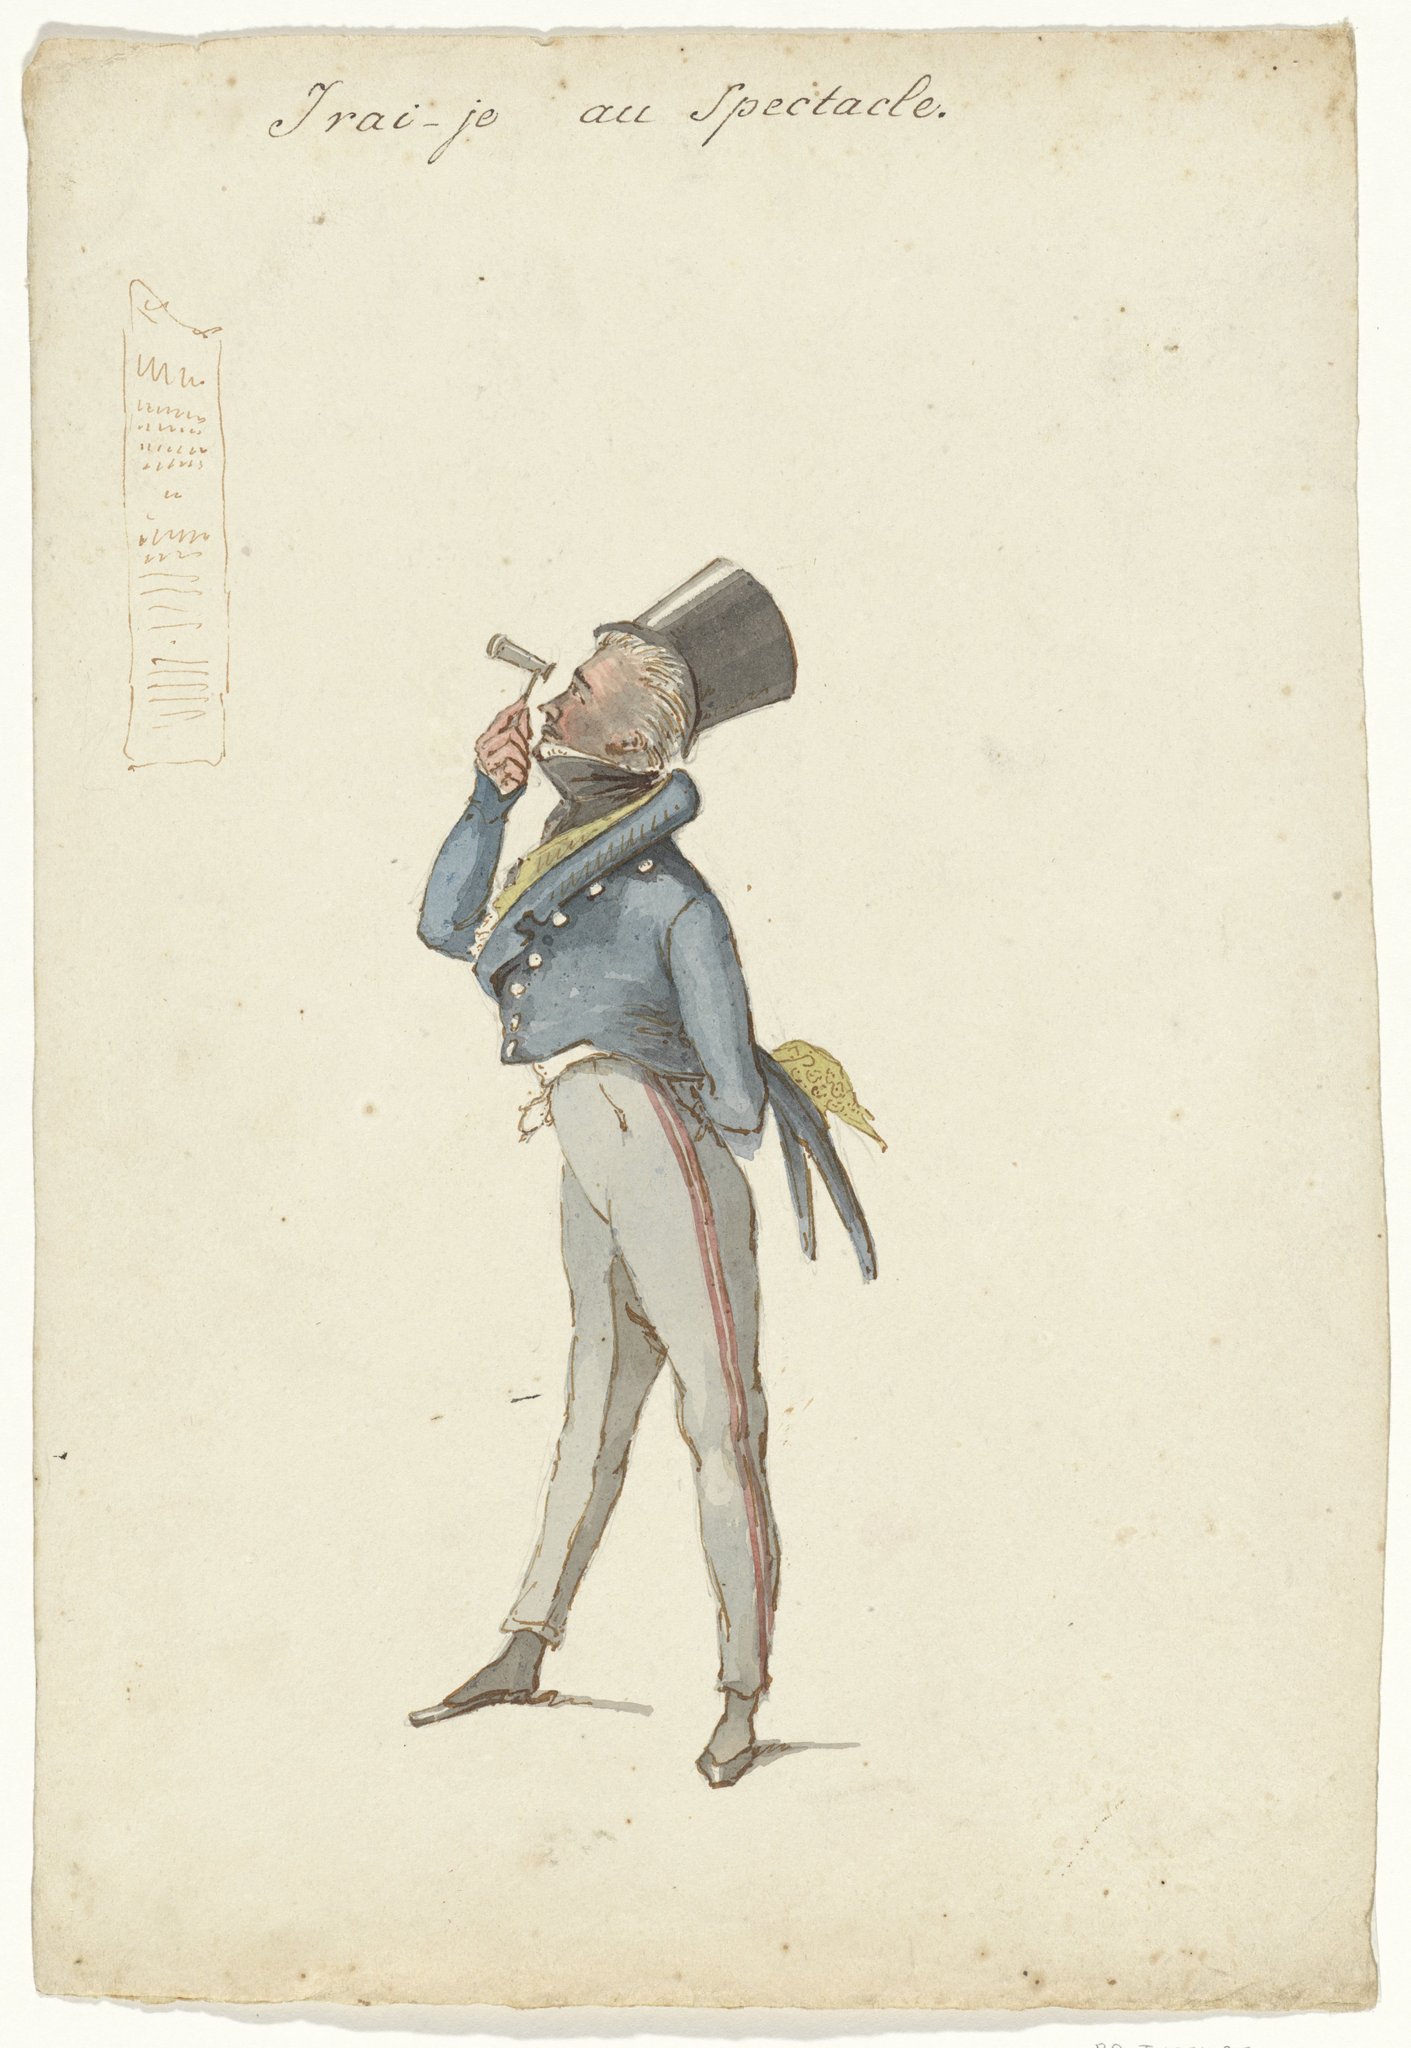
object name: drawing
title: Staande man met verrekijkertje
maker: pieter van loon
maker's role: draughtsman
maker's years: 1801-1873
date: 1811-1873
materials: ink, paper, pencil, watercolor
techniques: brush, pen